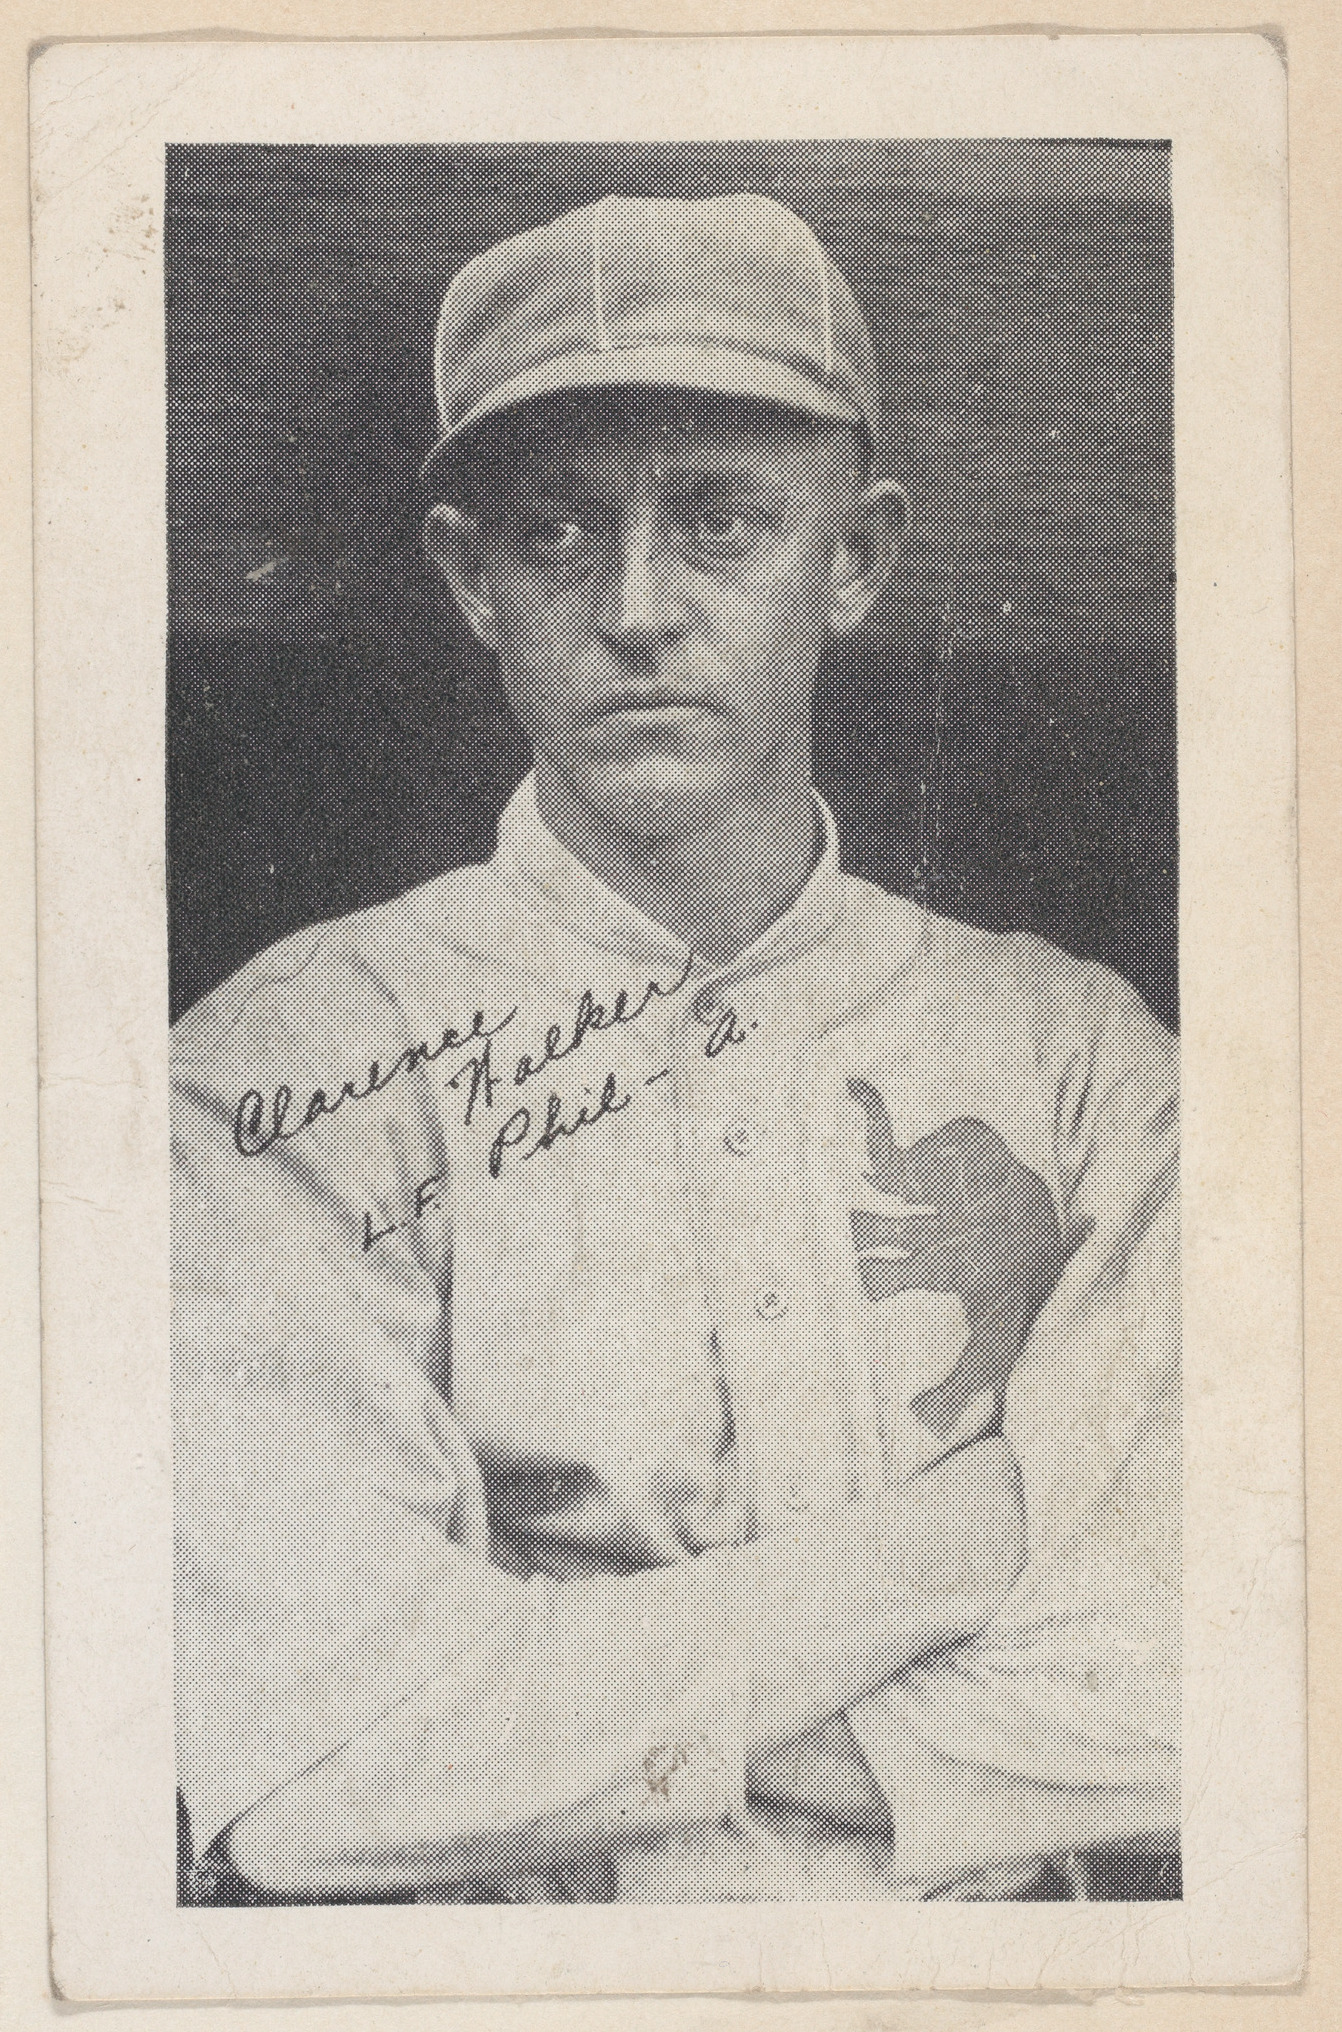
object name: print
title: Clarence Walker, L.F. Phil - A., from Baseball strip cards (W575-2)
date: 1921-1922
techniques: photolithograph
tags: men,portraits,baseball,athletes